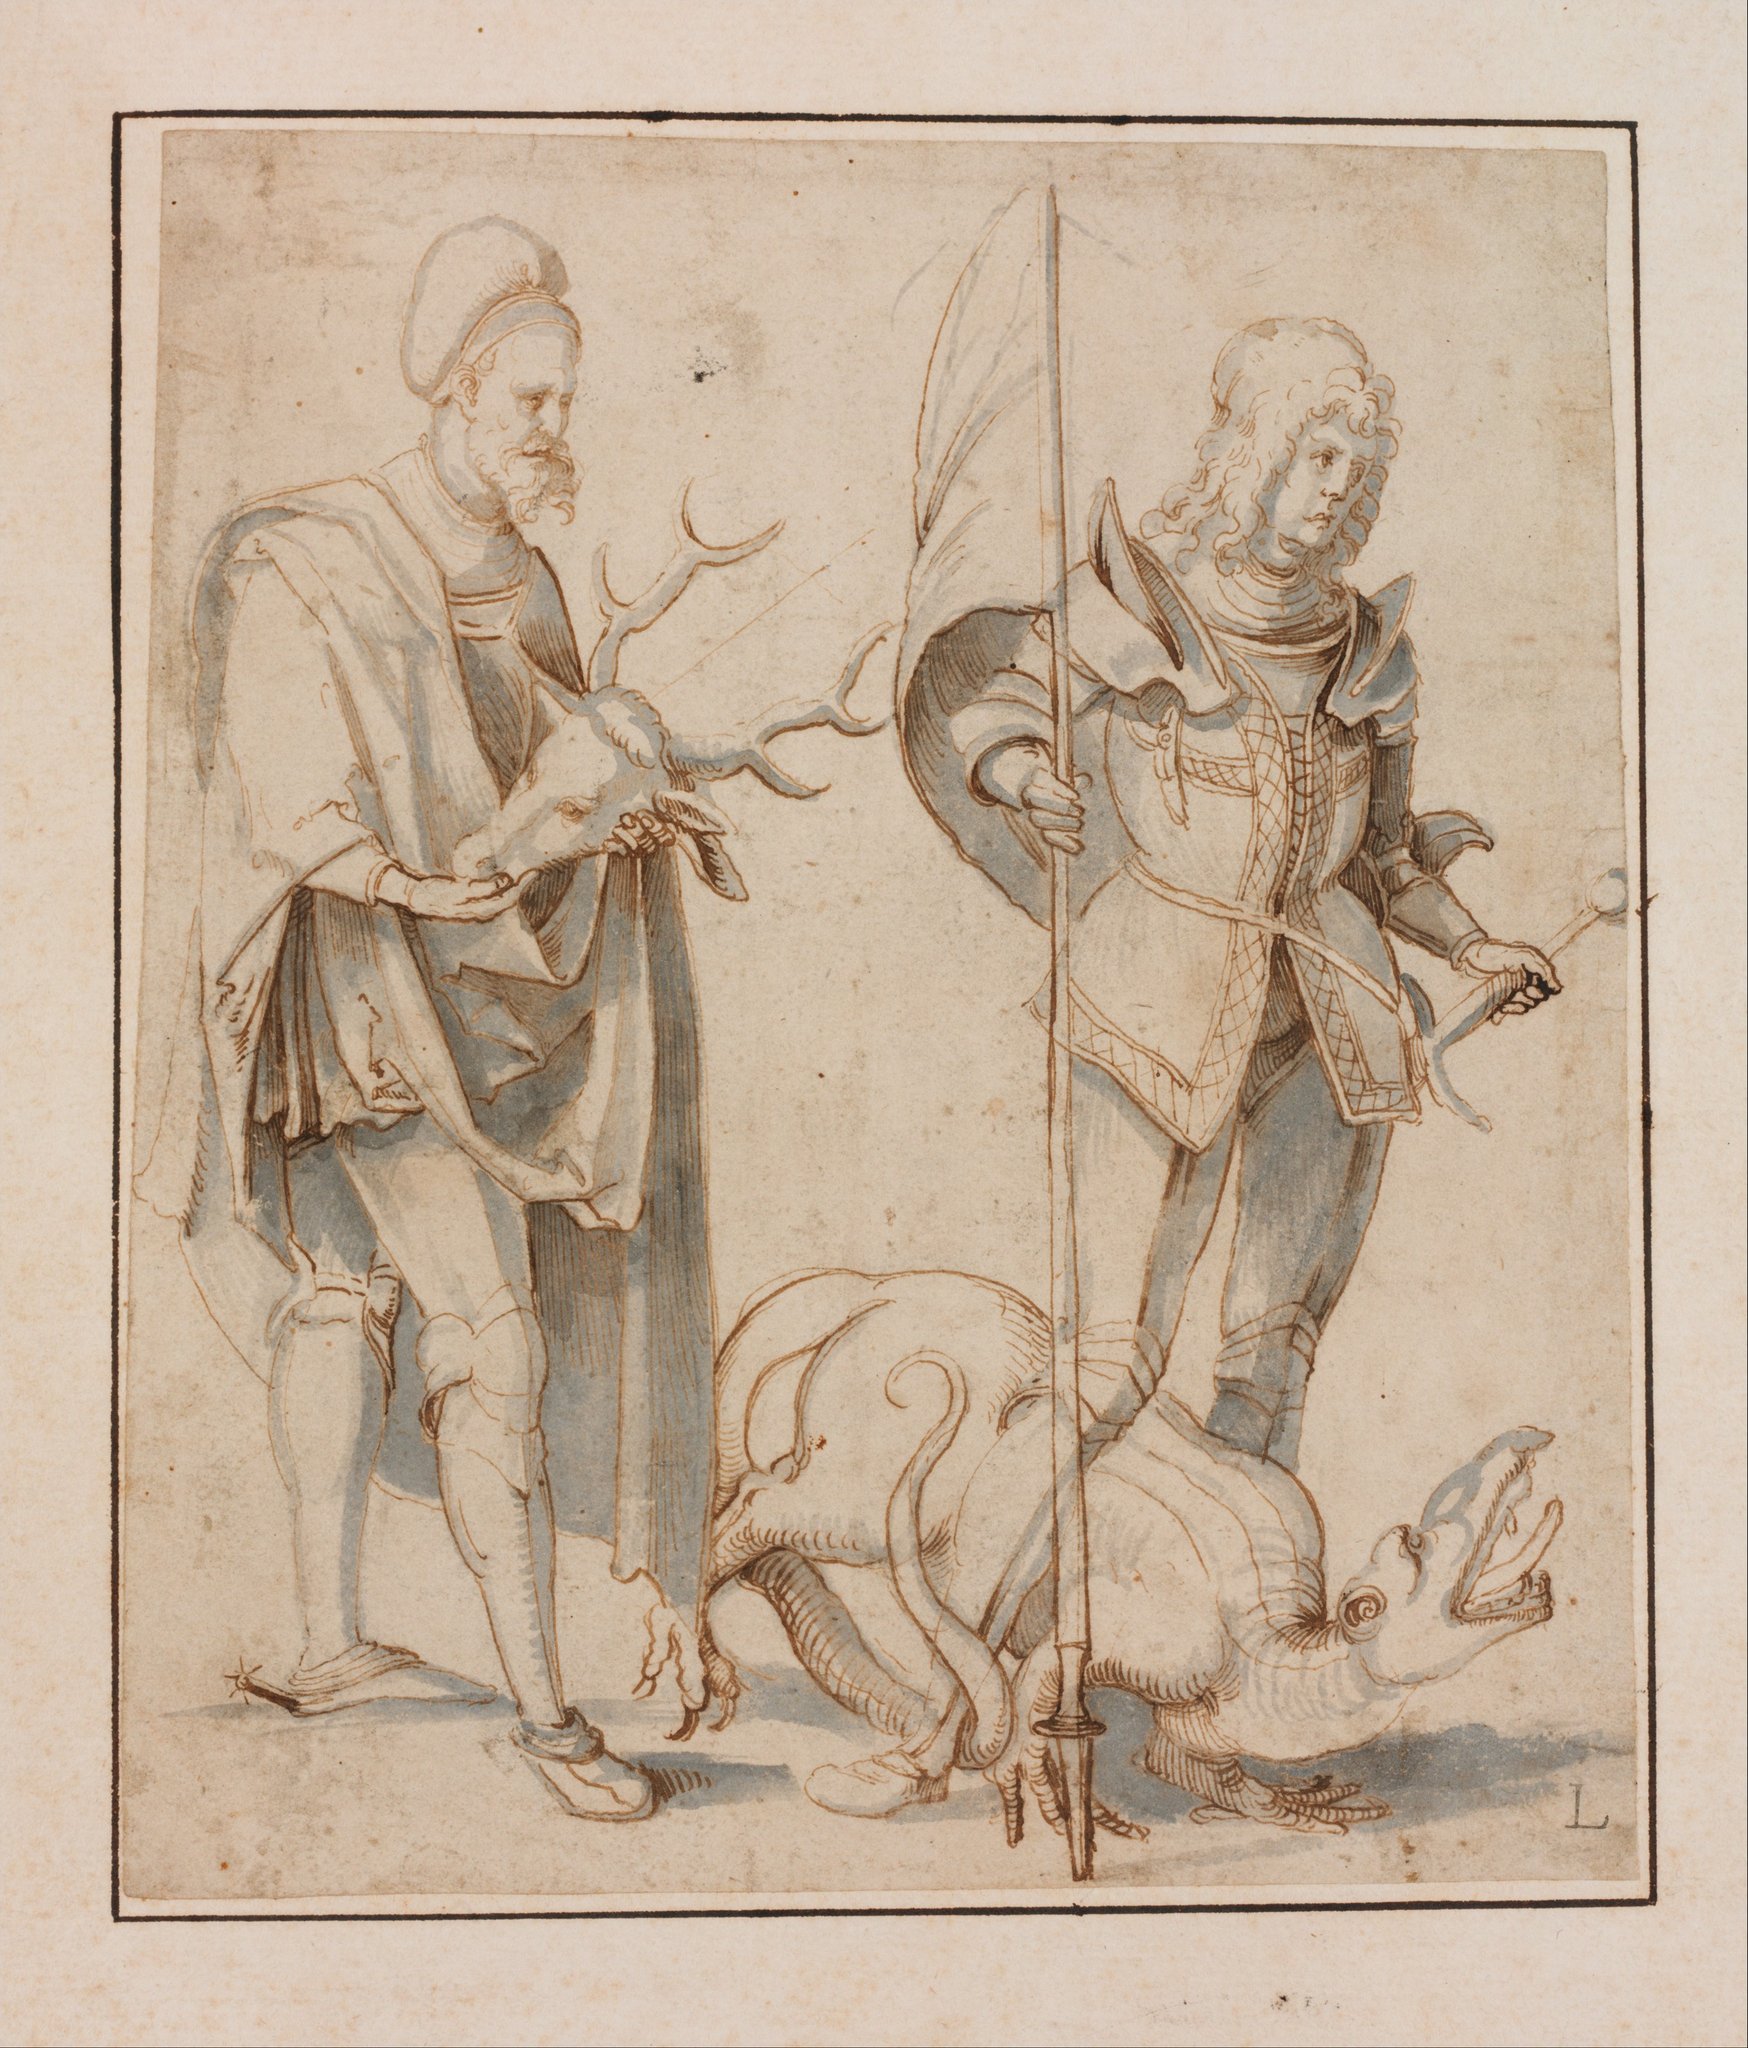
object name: drawing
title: Saint Eustace and Saint George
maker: hans süss von kulmbach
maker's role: artist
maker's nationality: german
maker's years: 1480-1522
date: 1511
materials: ink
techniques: brush, pen, wash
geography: germany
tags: deer,saint george,saints,flags